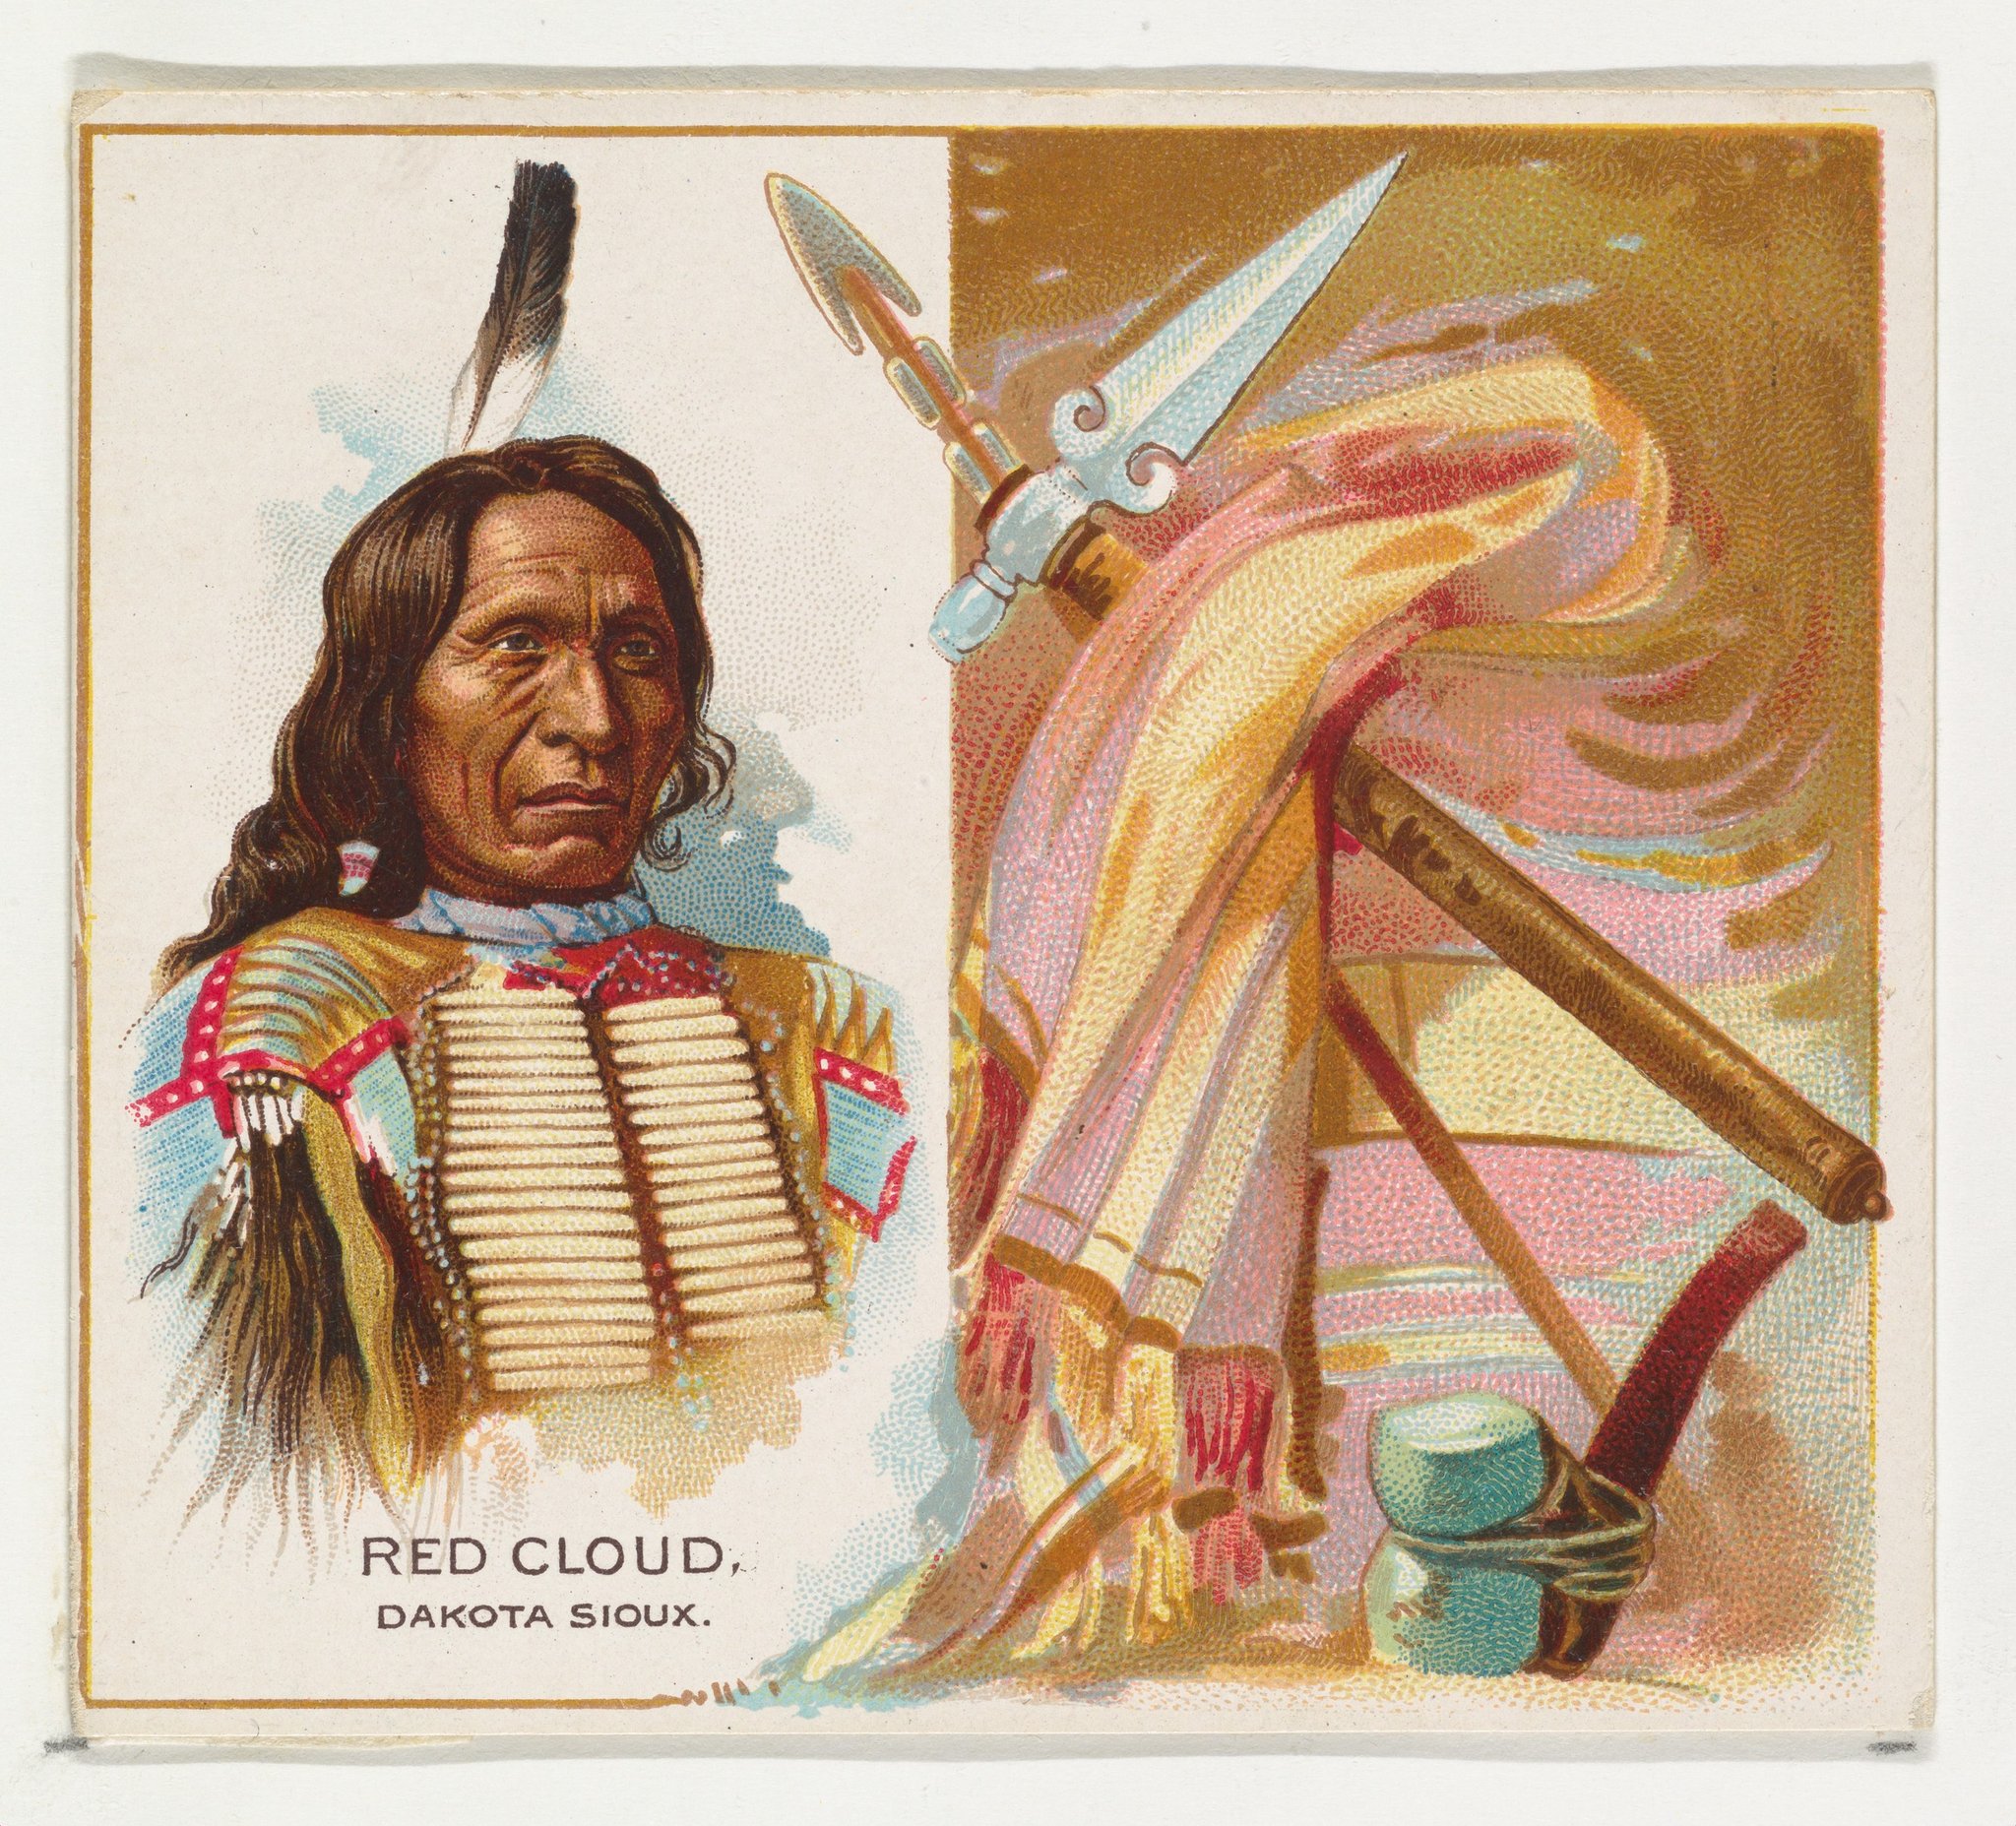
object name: print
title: Red Cloud, Dakota Sioux, from the American Indian Chiefs series (N36) for Allen & Ginter Cigarettes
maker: allen & ginter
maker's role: publisher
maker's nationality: american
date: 1888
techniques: color lithograph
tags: weapons,men